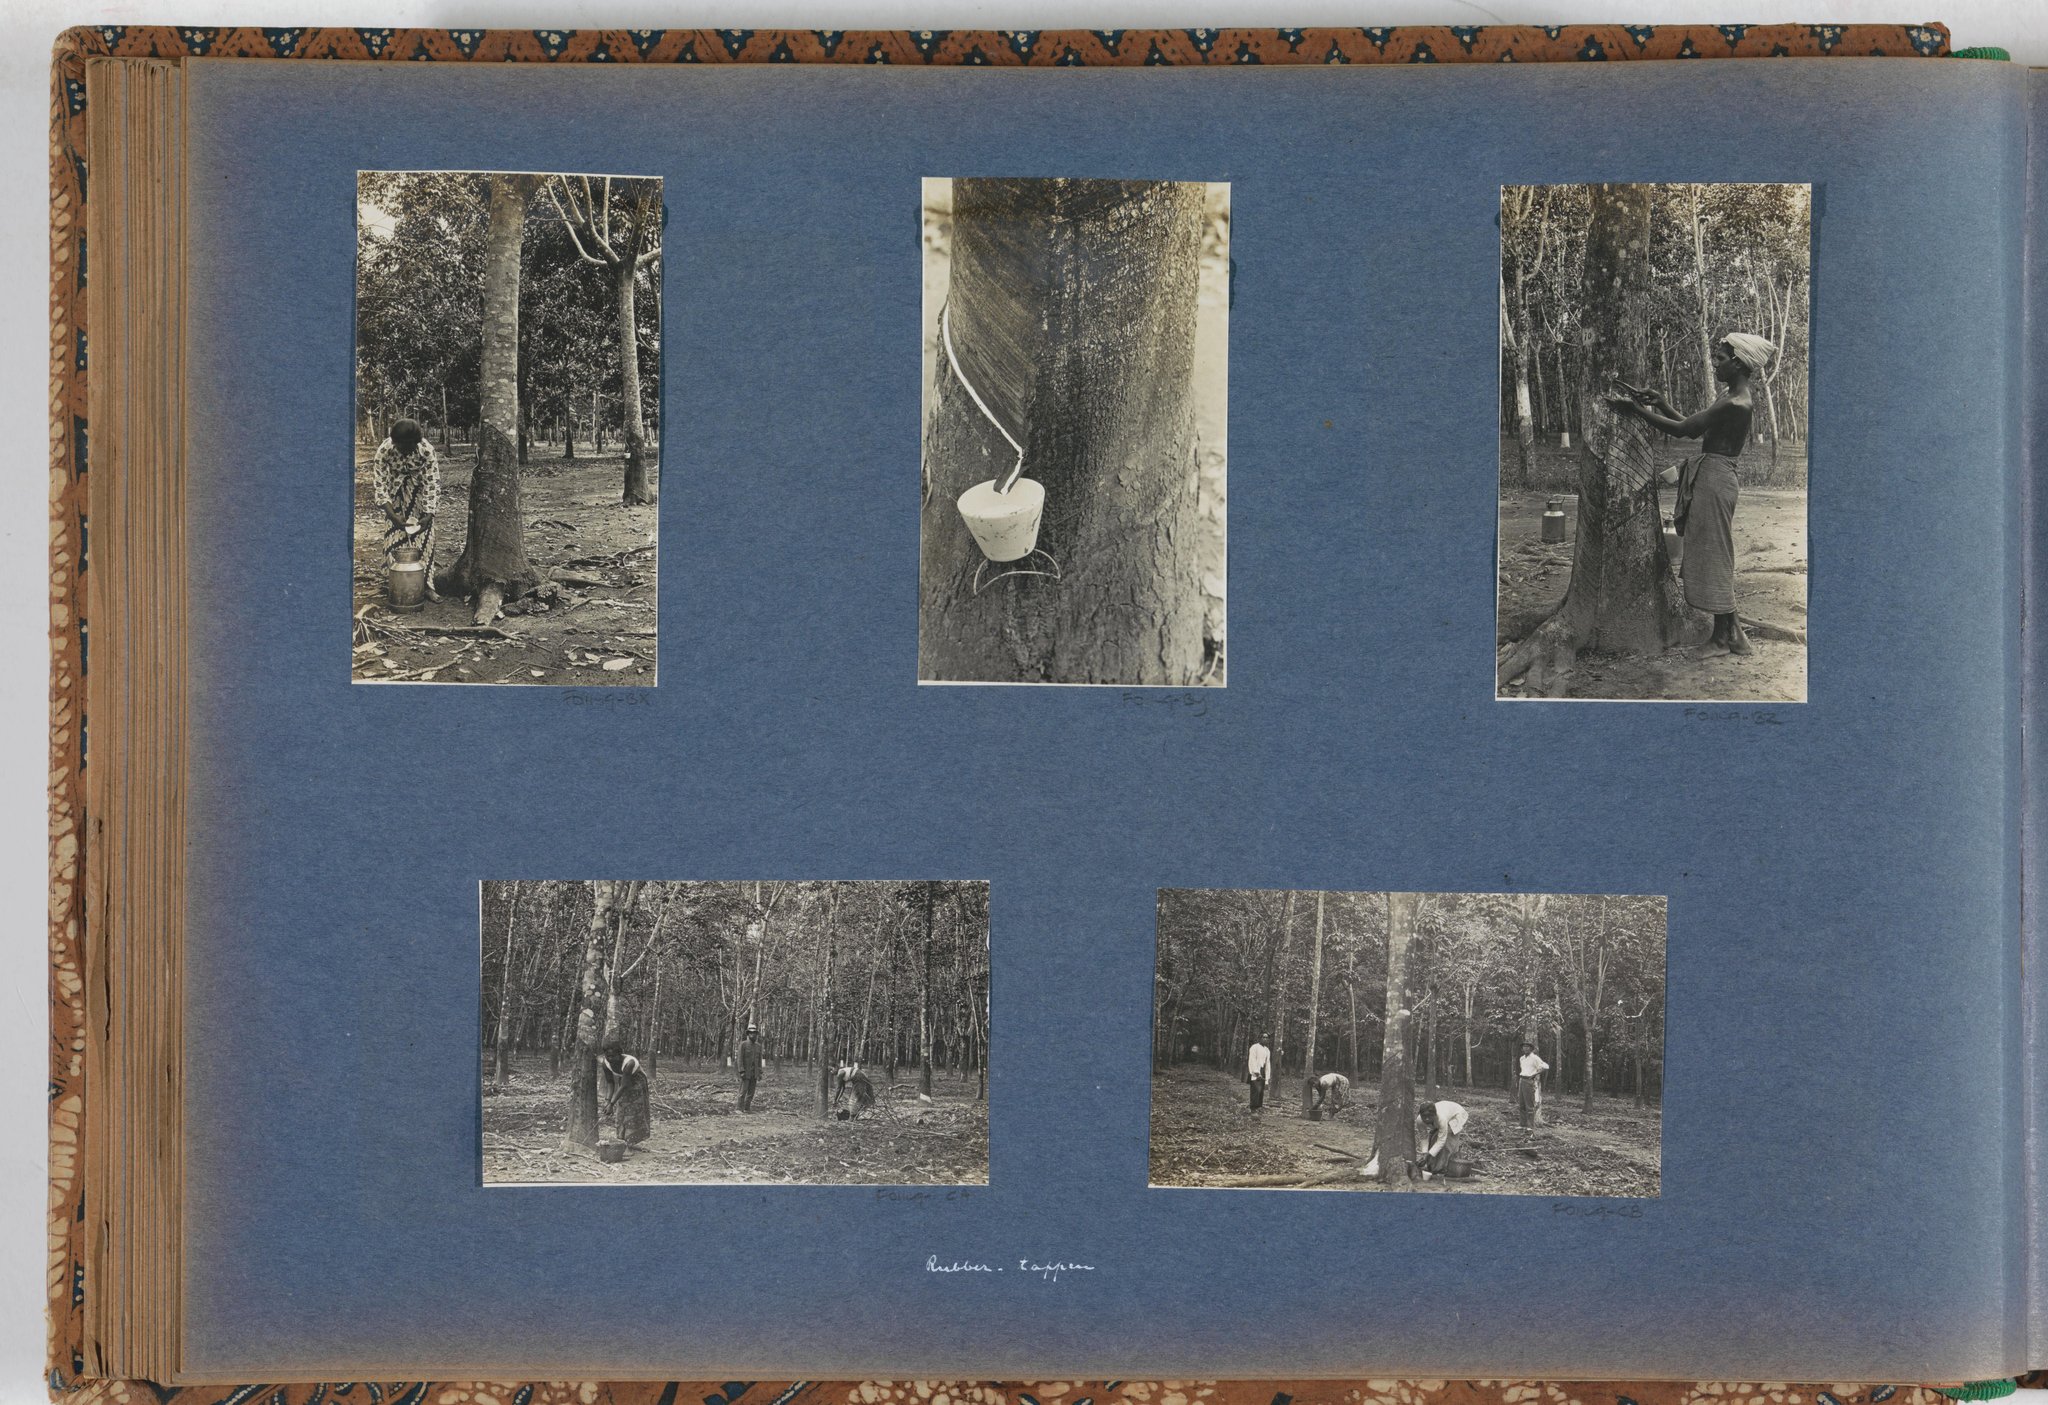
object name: photograph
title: Kom aan een boom voor het opvangen van latex (rubbersap) op een plantage op Sumatra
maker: Anonymous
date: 1900-1920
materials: paper, photographic support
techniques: gelatin silver print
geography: sumatra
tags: plantation, (non-fruit) products of plants or trees: rubber, bowl, sumatra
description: Onderdeel van reisalbum met foto's van bedrijvigheid en bezienswaardigheden op Sumatra en Java en van de reis naar en van Nederlands-Indië.